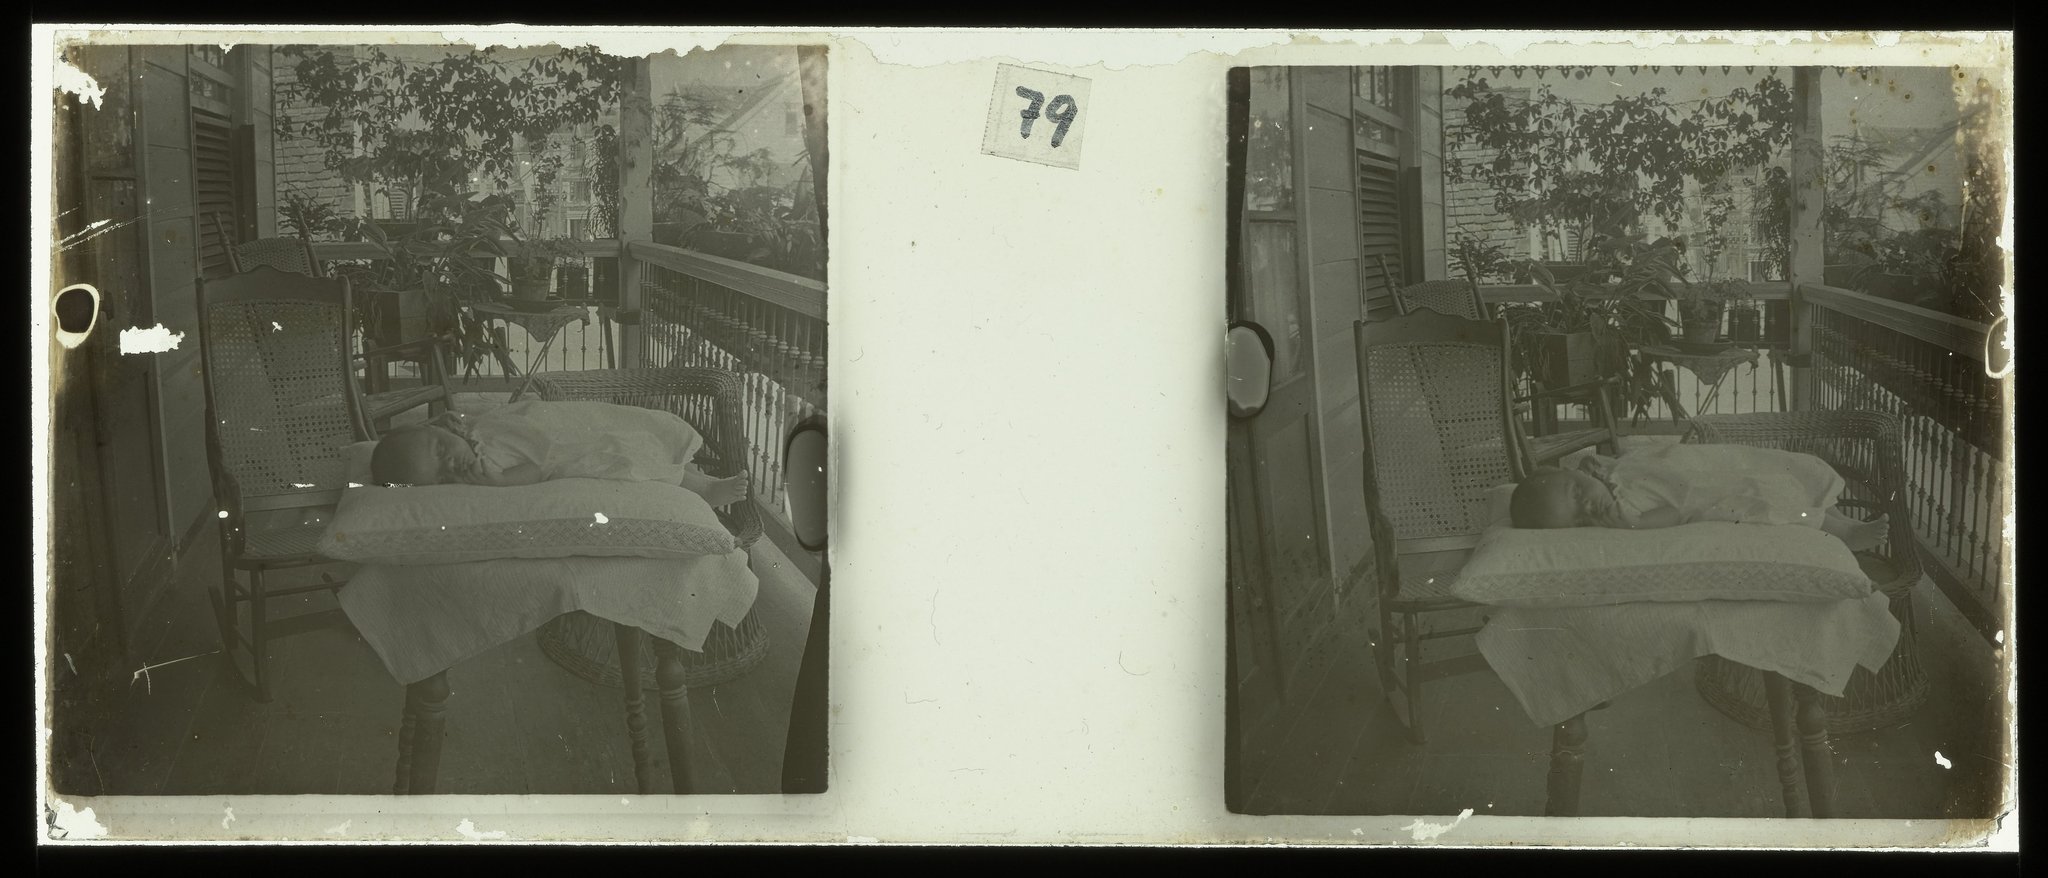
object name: stereograph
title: Gerard Brouwers op de veranda van Plantage Accaribo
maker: theodoor brouwers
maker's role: amateurfotograaf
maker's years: 1874-1932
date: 1913-1930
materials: glass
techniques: photography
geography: suriname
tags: amsterdam, theodoor brouwers, plantation, suriname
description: In de periode 1911-1932 woonde op plantage Accaribo in Suriname de familie Brouwers van wie de foto's afkomstig zijn. Rond 1910 vond Theodoor Brouwers werk op plantage Accaribo. In 1929 werd hij eigenaar van de plantage. Op Accaribo werden in zijn tijd bananen geproduceerd en wat koffie.